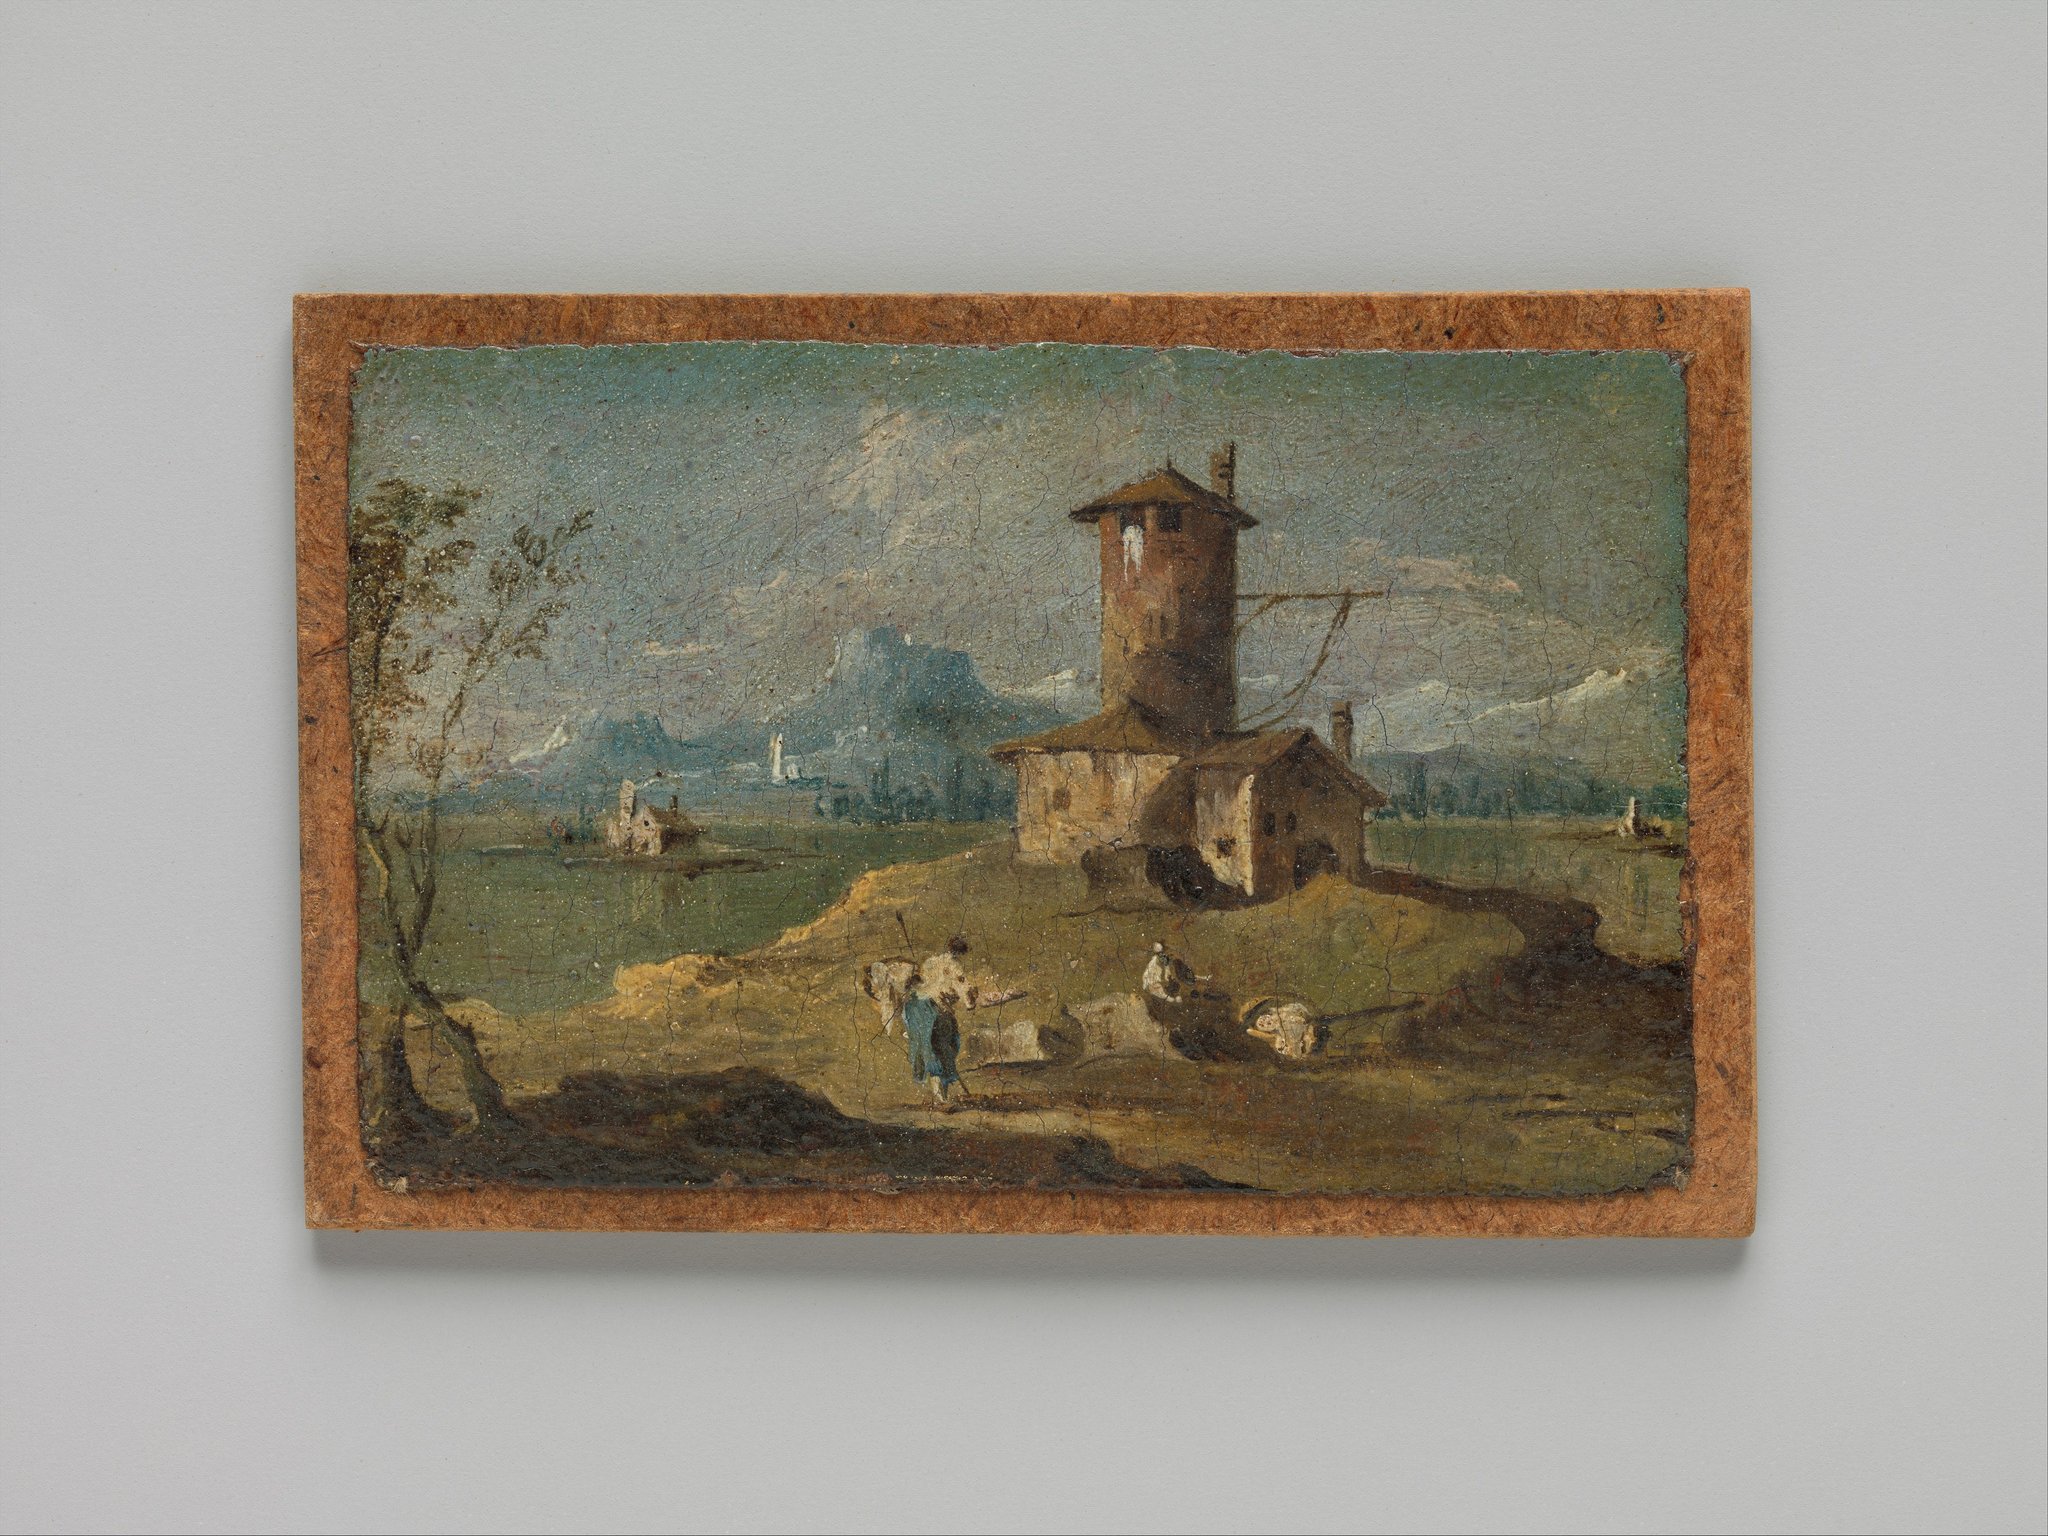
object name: painting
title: Capriccio with an Island, a Tower, and Houses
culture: italian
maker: francesco guardi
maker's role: artist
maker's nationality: italian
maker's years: 1712-1793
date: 1701-1800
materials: oil, paper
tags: houses,towers,landscapes